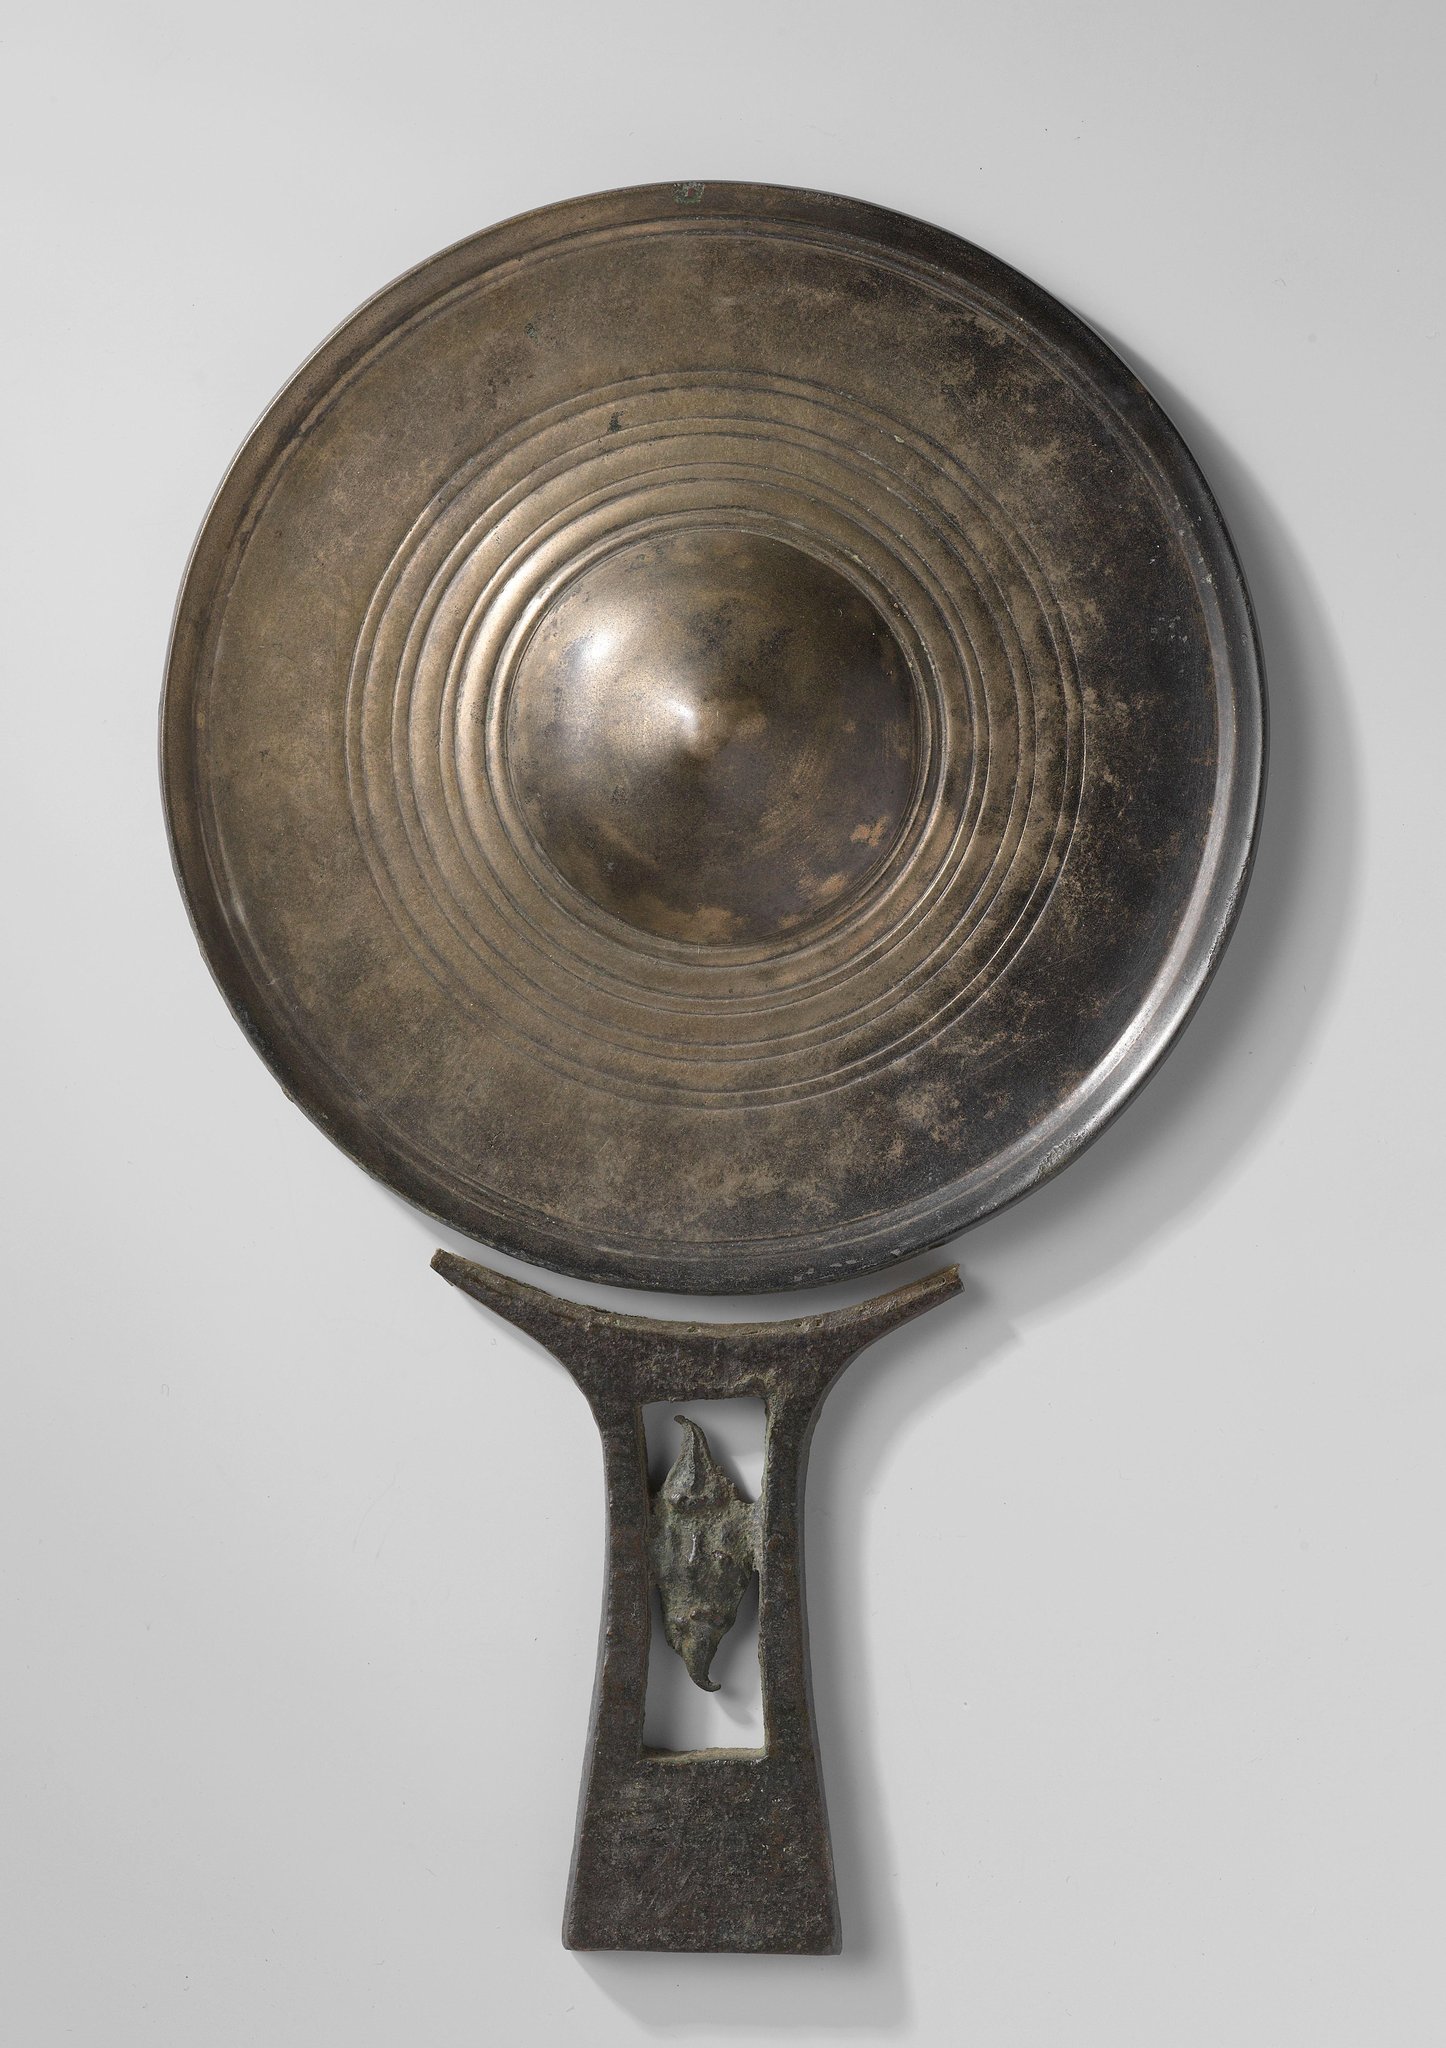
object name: mirror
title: Mirrors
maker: Anonymous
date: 1300-1600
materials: bronze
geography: indonesia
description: In making these mirrors the disk and the handle were cast separately. The bronze disc was polished to a high shine and the handle adorned with decorative details, such as openwork motifs or gilded reliefs. Bronze mirrors could also have a ritual function, whereby the image of the divinity was reflected in the polished surface and thus establishing a connection between the spiritual and the mundane worlds.